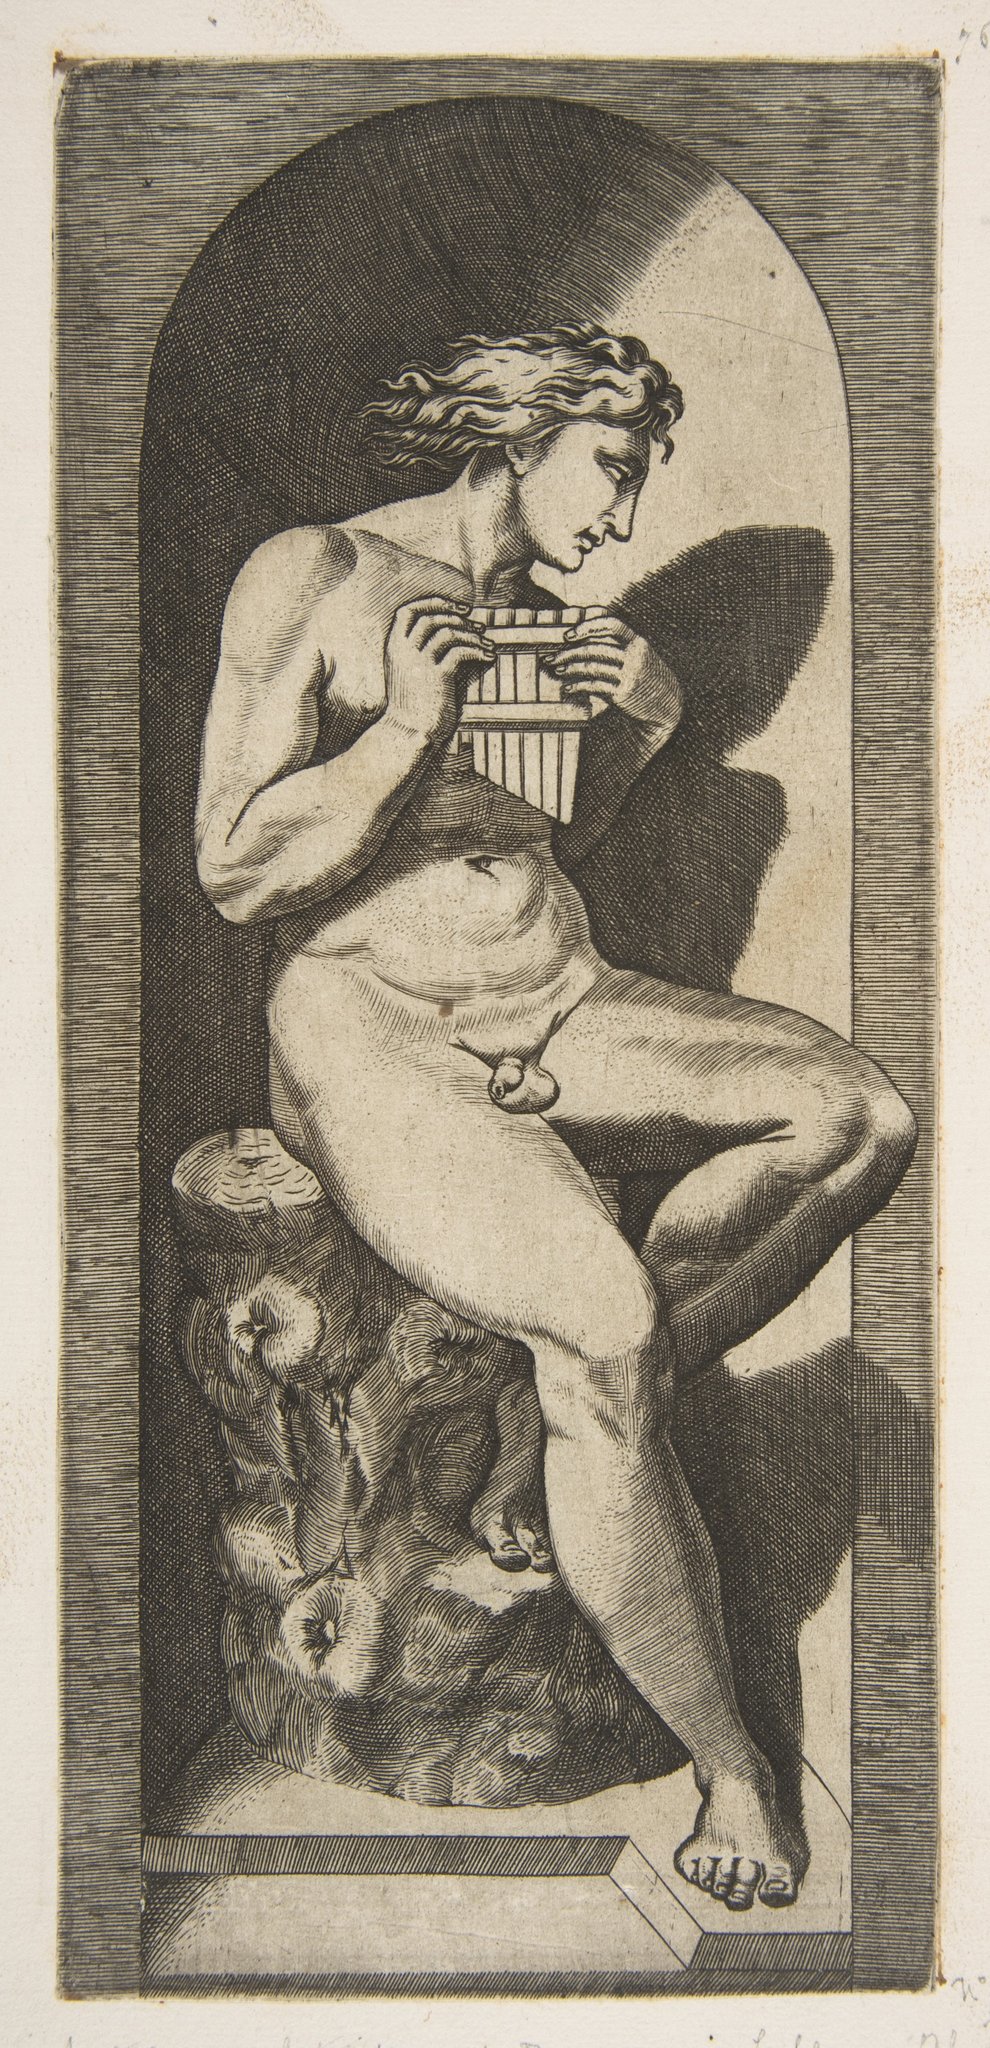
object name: print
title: Olympus naked seated on a tree stump holding pipes, set within a niche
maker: marco dente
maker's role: artist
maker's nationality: italian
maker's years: 1515-1527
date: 1515-1527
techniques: engraving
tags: male nudes,trees